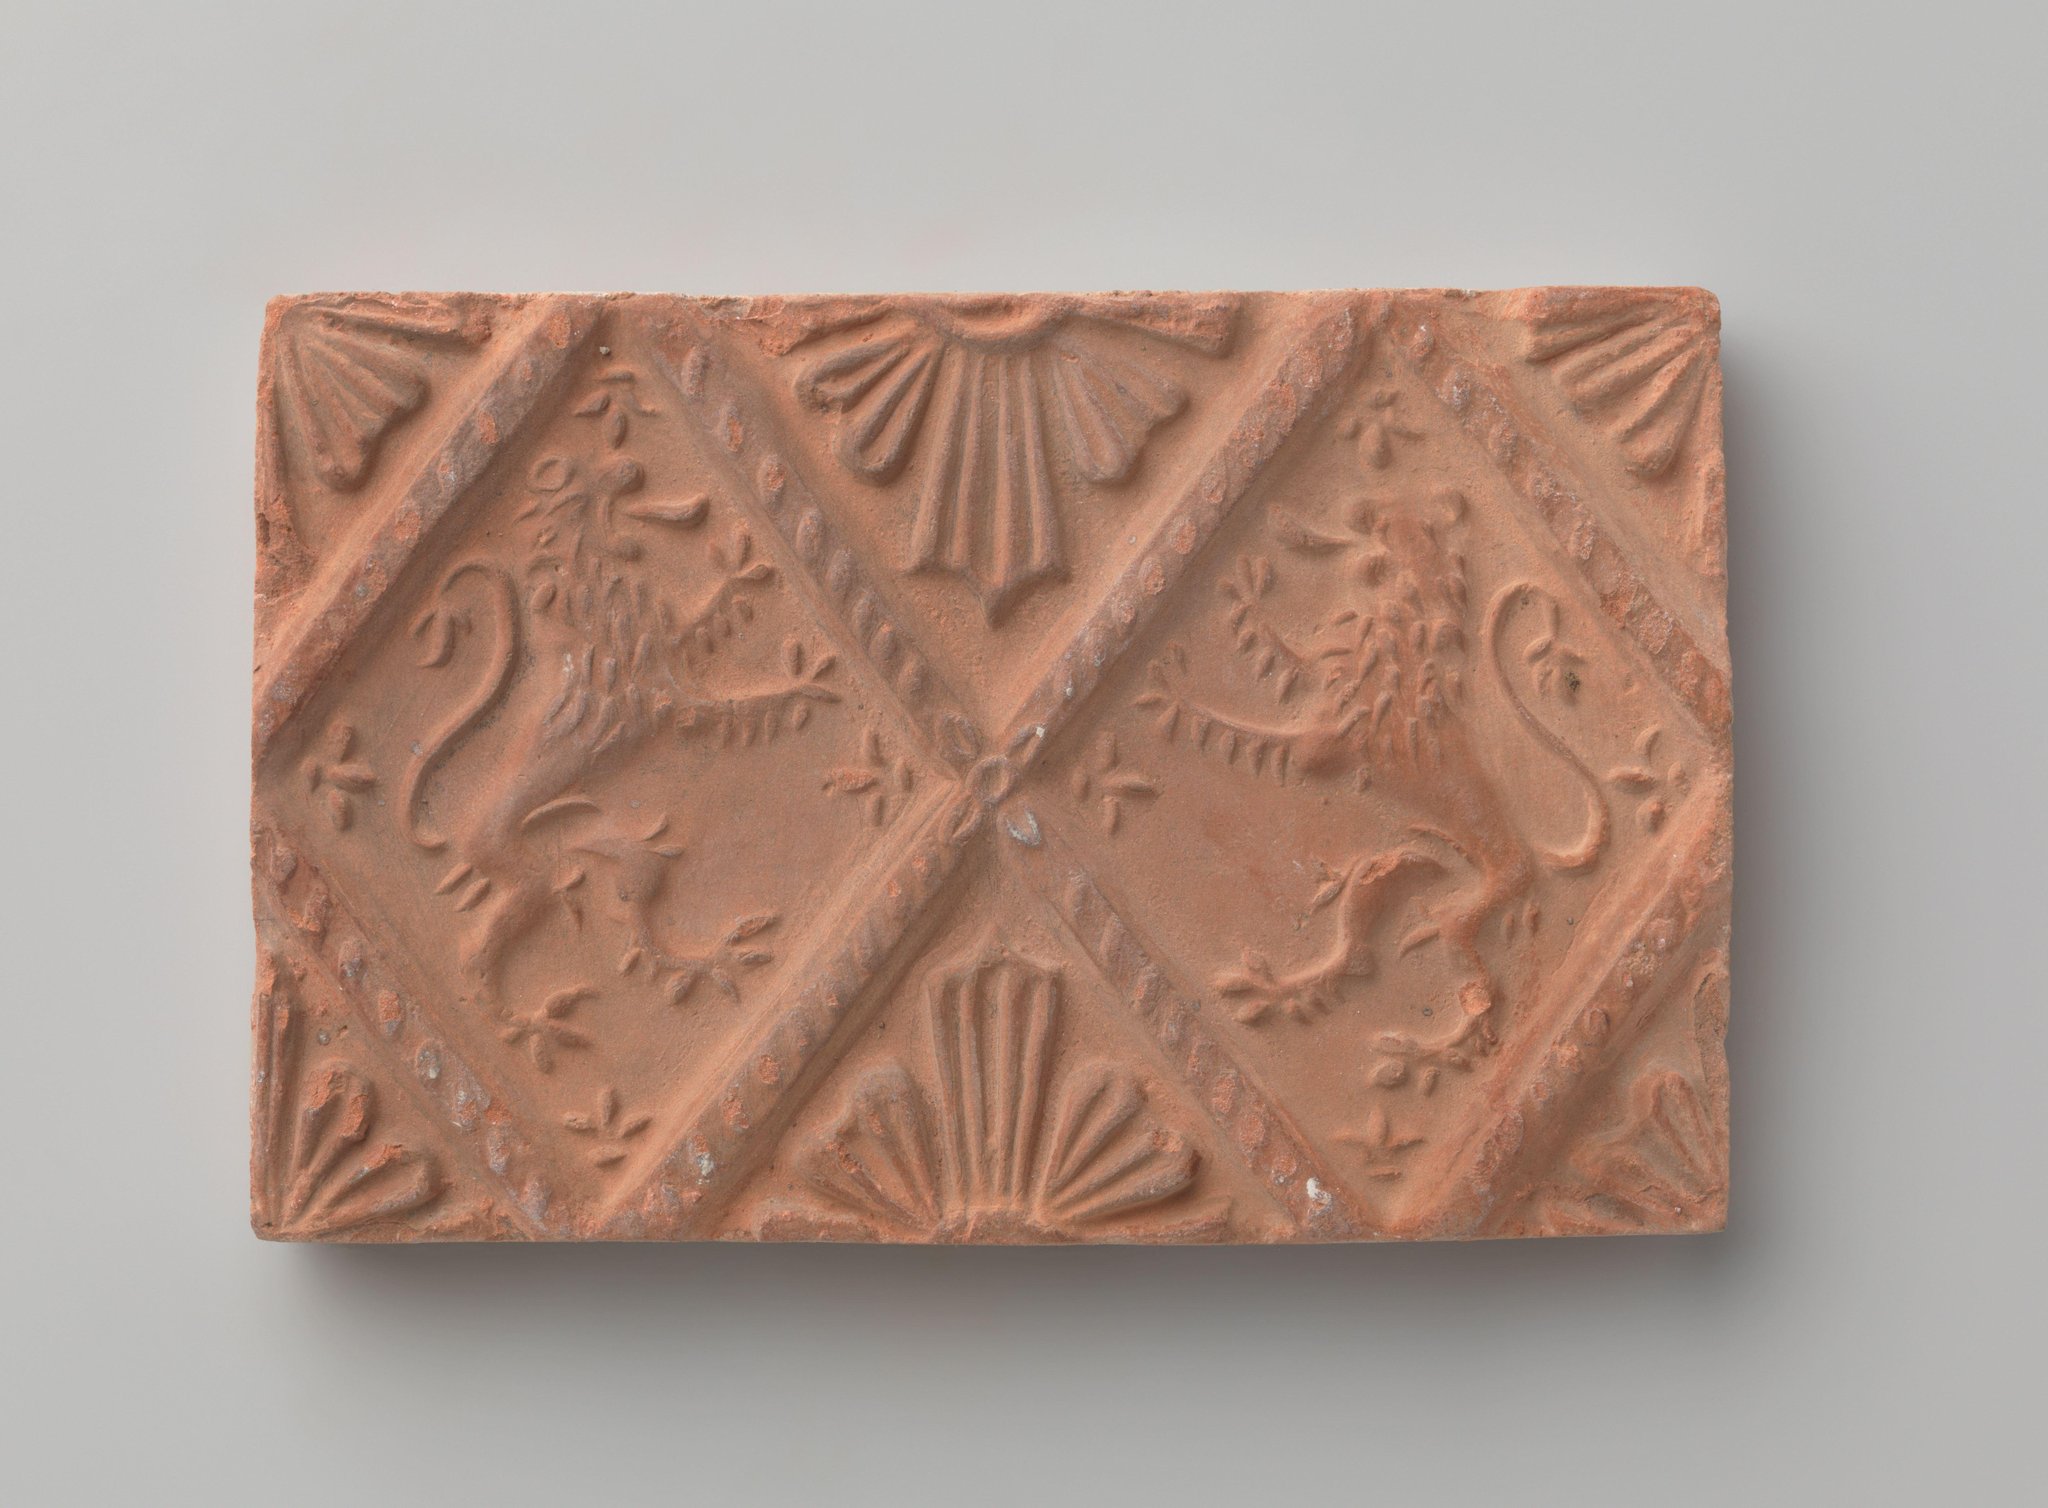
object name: hearthstone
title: Haardsteen met voorstelling van twee klimmende leeuwen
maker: Anonymous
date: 1875-1900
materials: earthenware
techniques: printing, firing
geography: netherlands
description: Haardsteen met voorstelling van twee klimmende leeuwen, geplaatst in geprofileerde ruit. De halve ruiten aan de boven- en onderkant zijn opgevuld met stermotief.